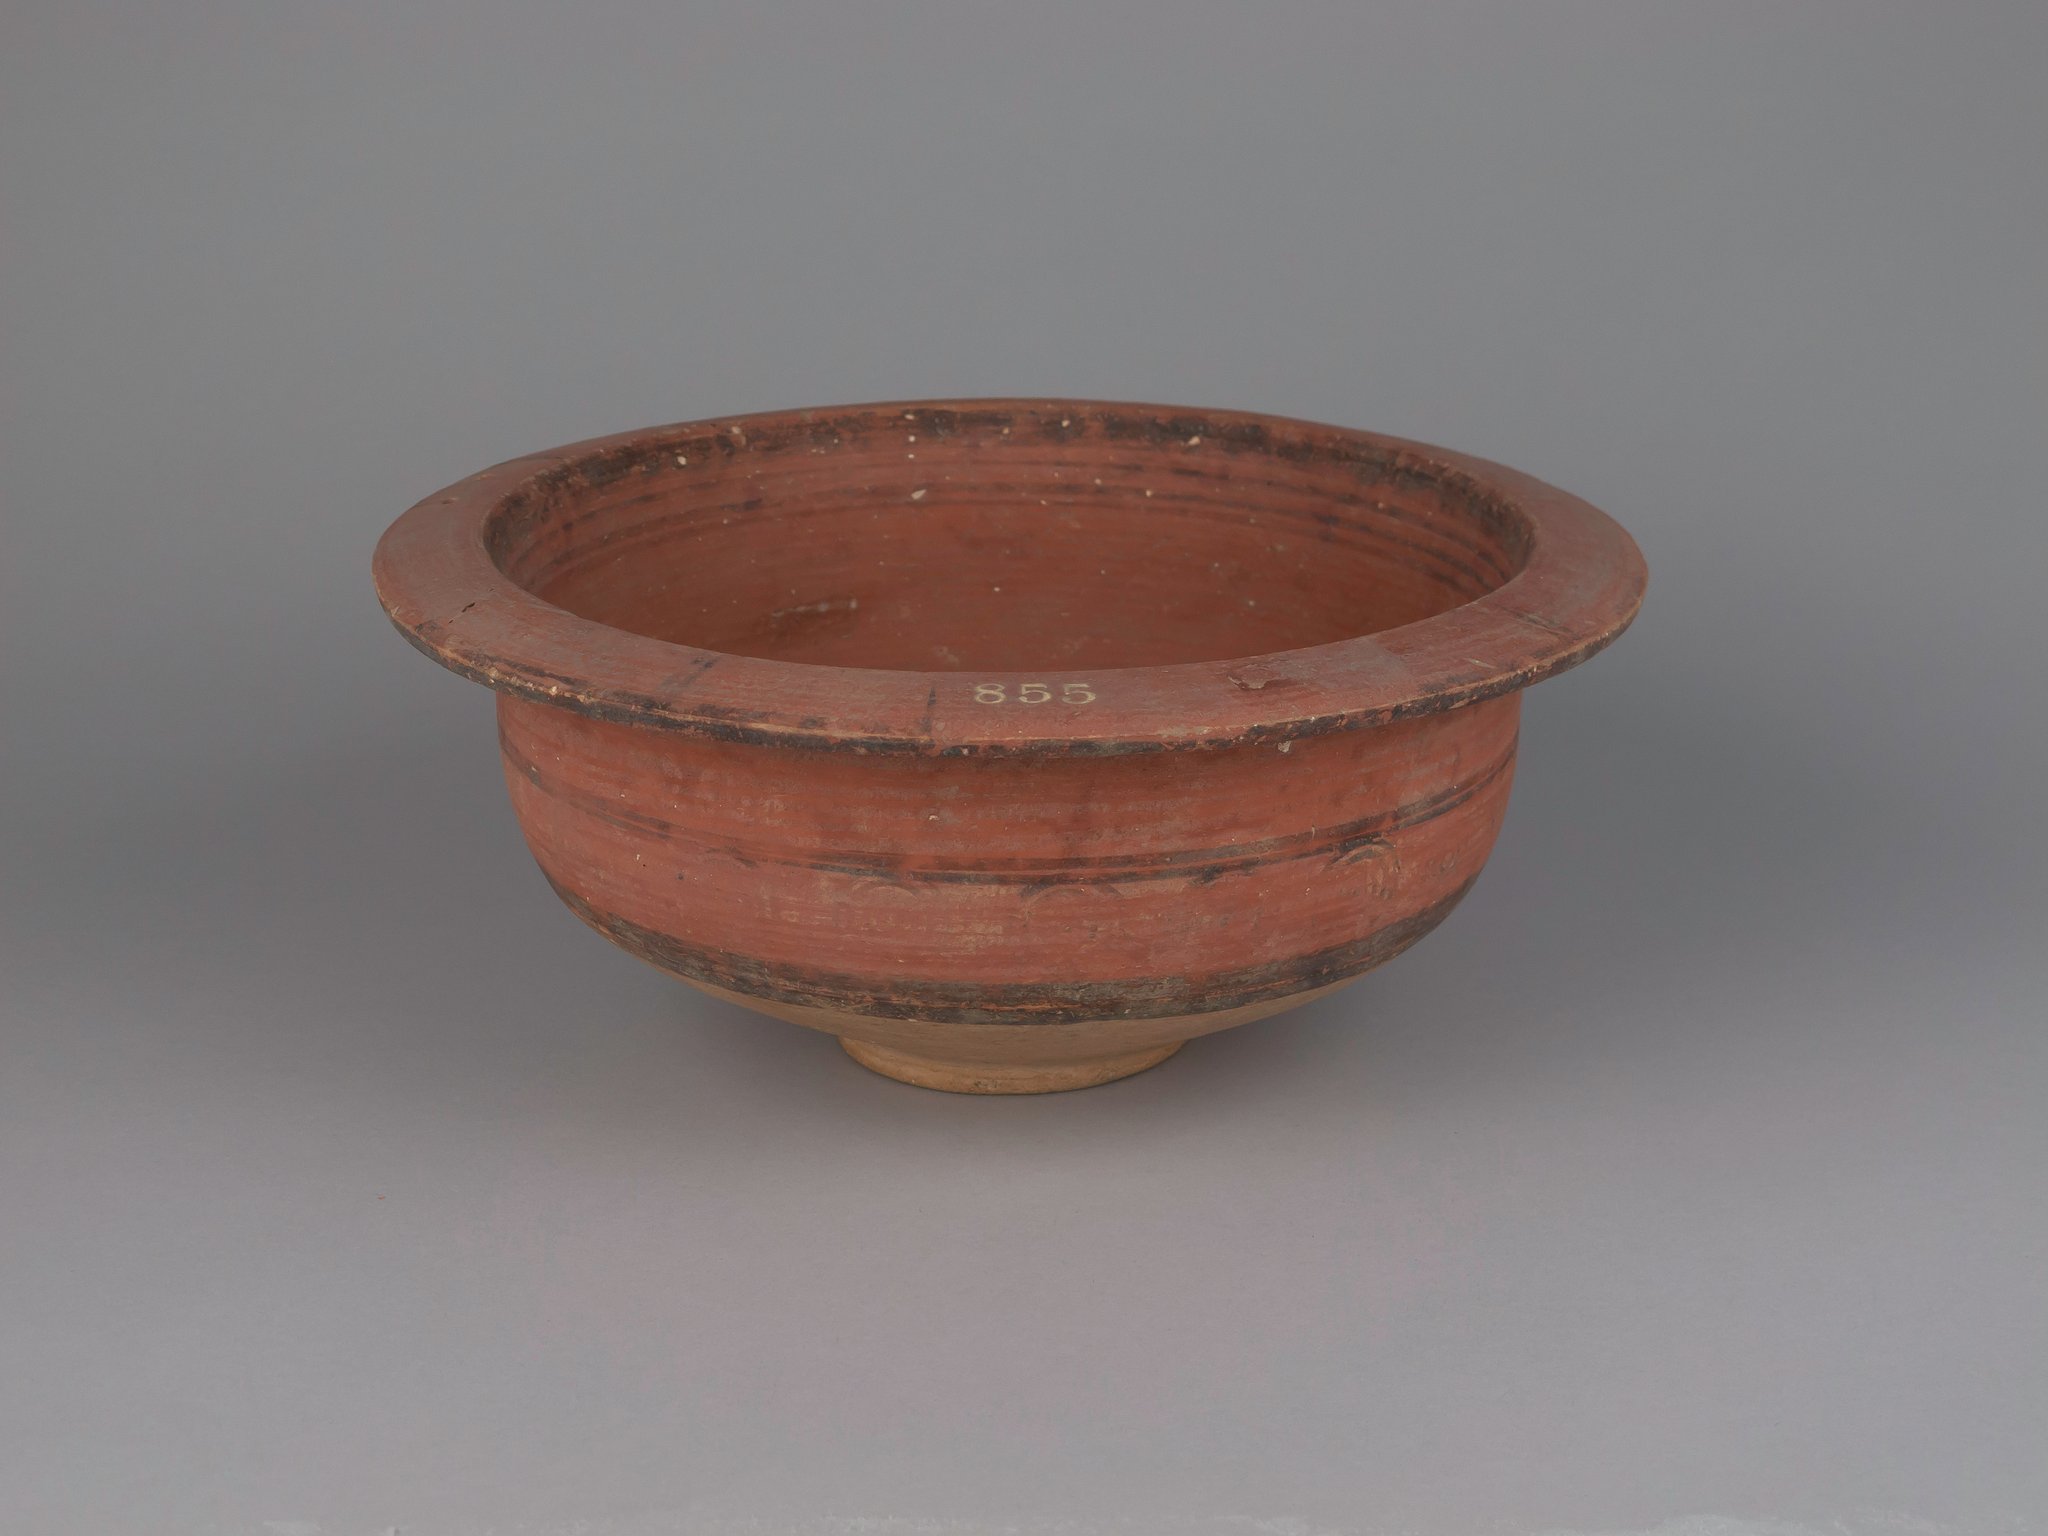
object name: bowl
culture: cypriot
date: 600-480 BCE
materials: terracotta